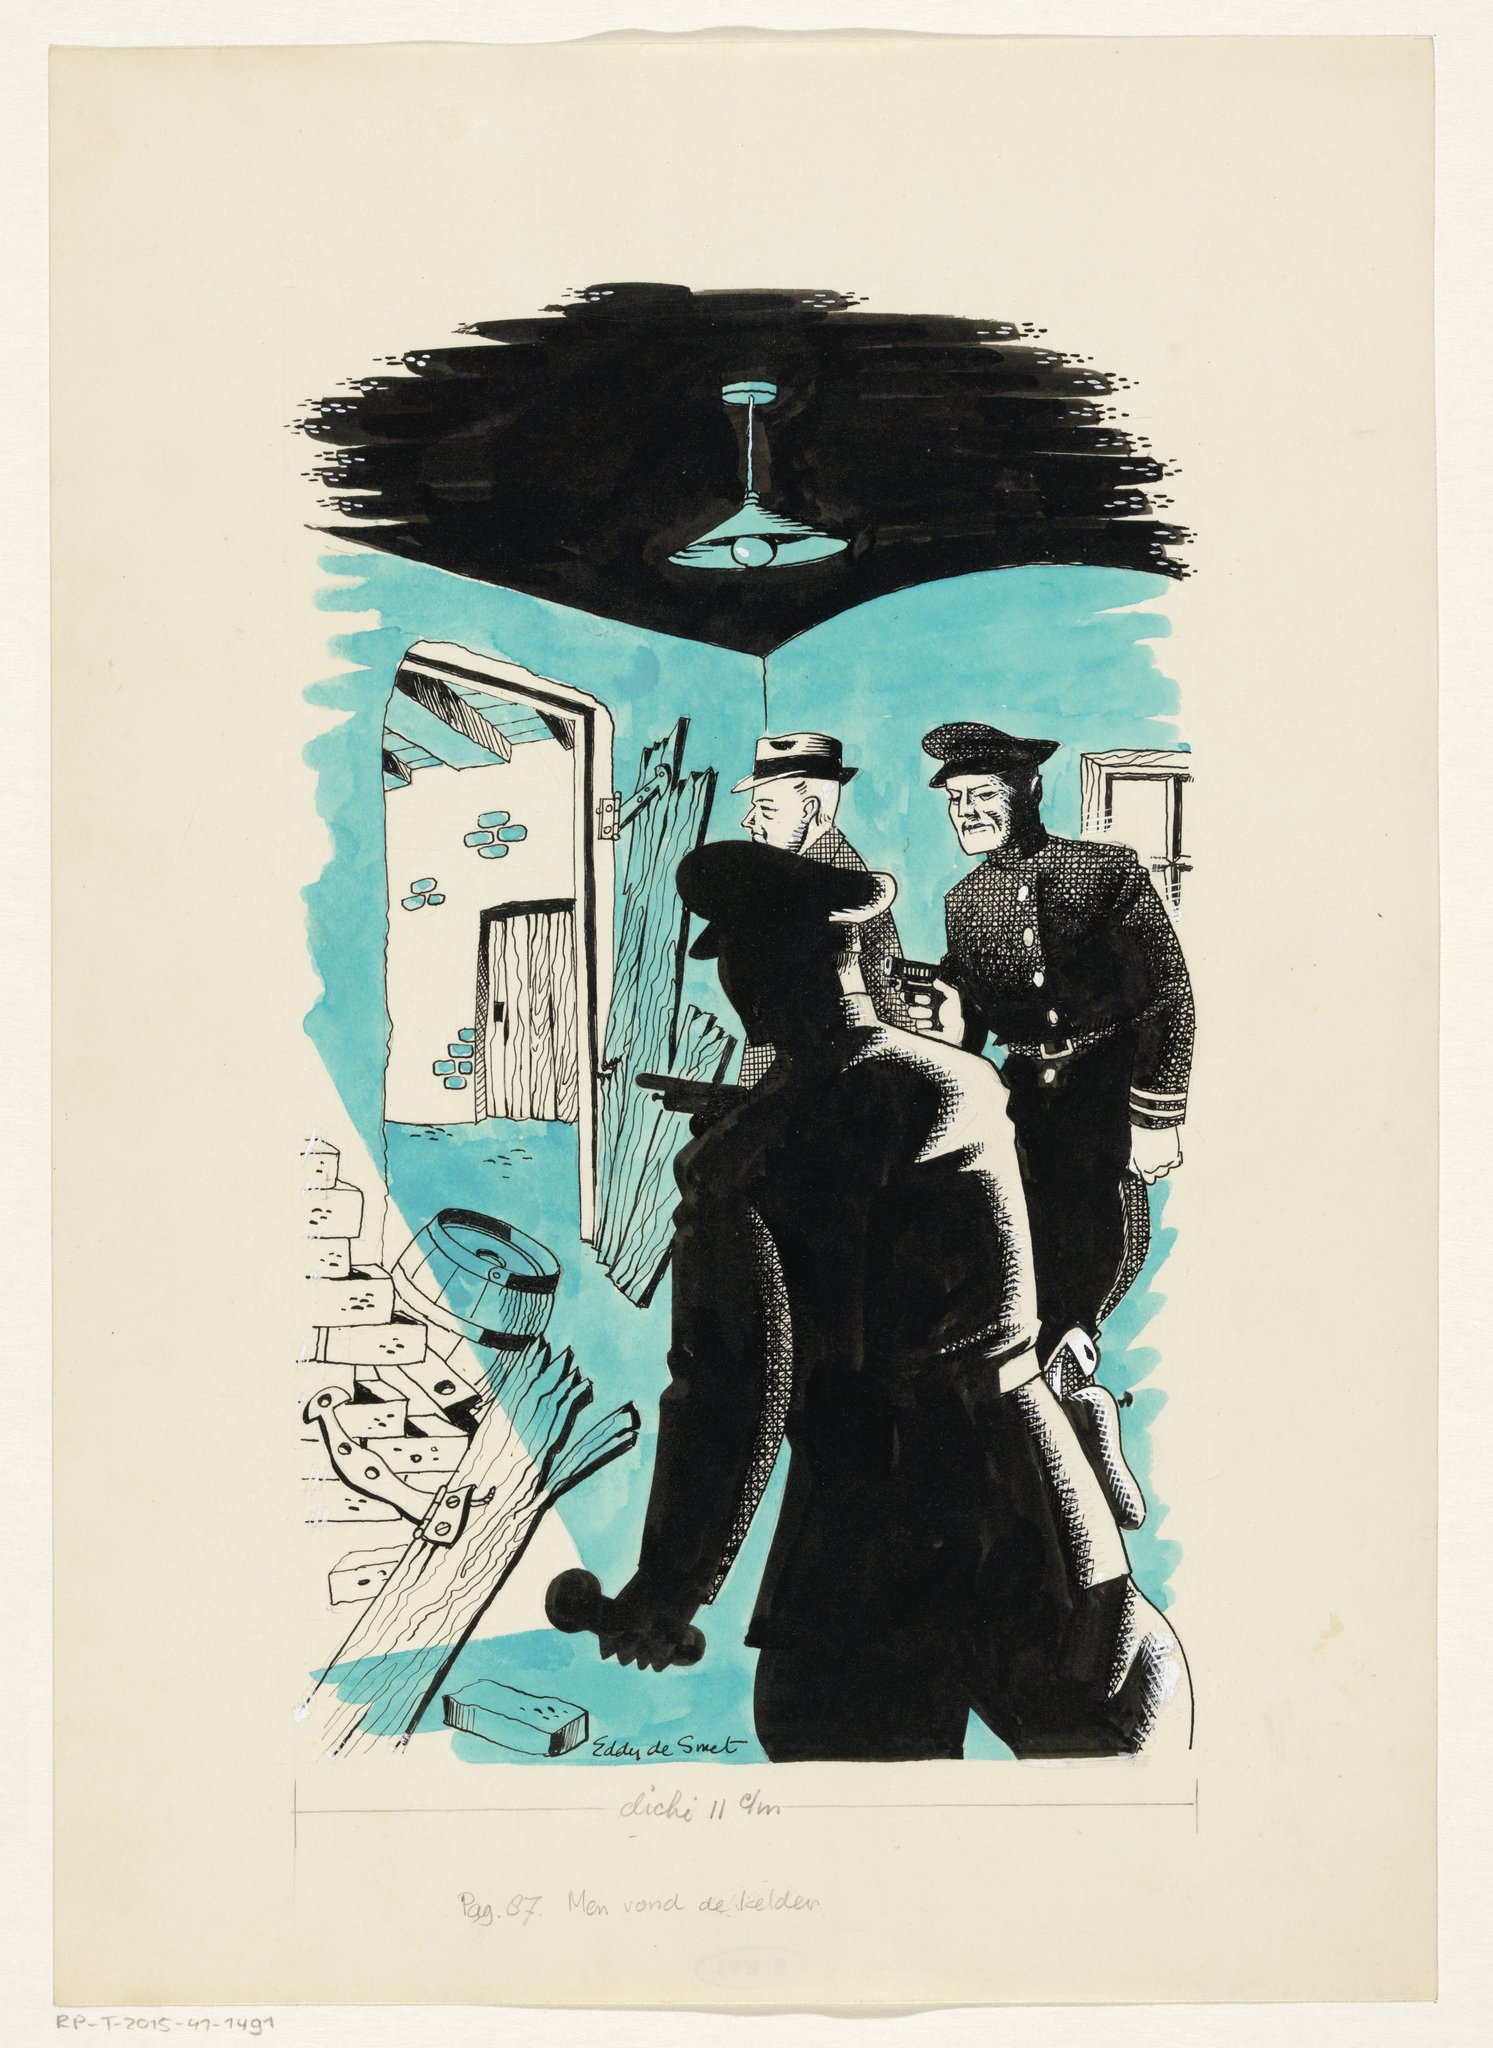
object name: drawing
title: Politieagenten in een kelder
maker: eddy de smet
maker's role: draughtsman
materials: paint, ink, paper, pencil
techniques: brush, pen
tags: policeman, constable, firearms, basement, cellar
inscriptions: annotation: ‘Pag. 87. Men vond de kelder’, signature: ‘Eddy de Smet’, collector's mark: Lugt 2228, :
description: Twee politiemannen doorzoeken met getrokken pistool een kelderruimte. In de achtergrond staat een man met hoed.